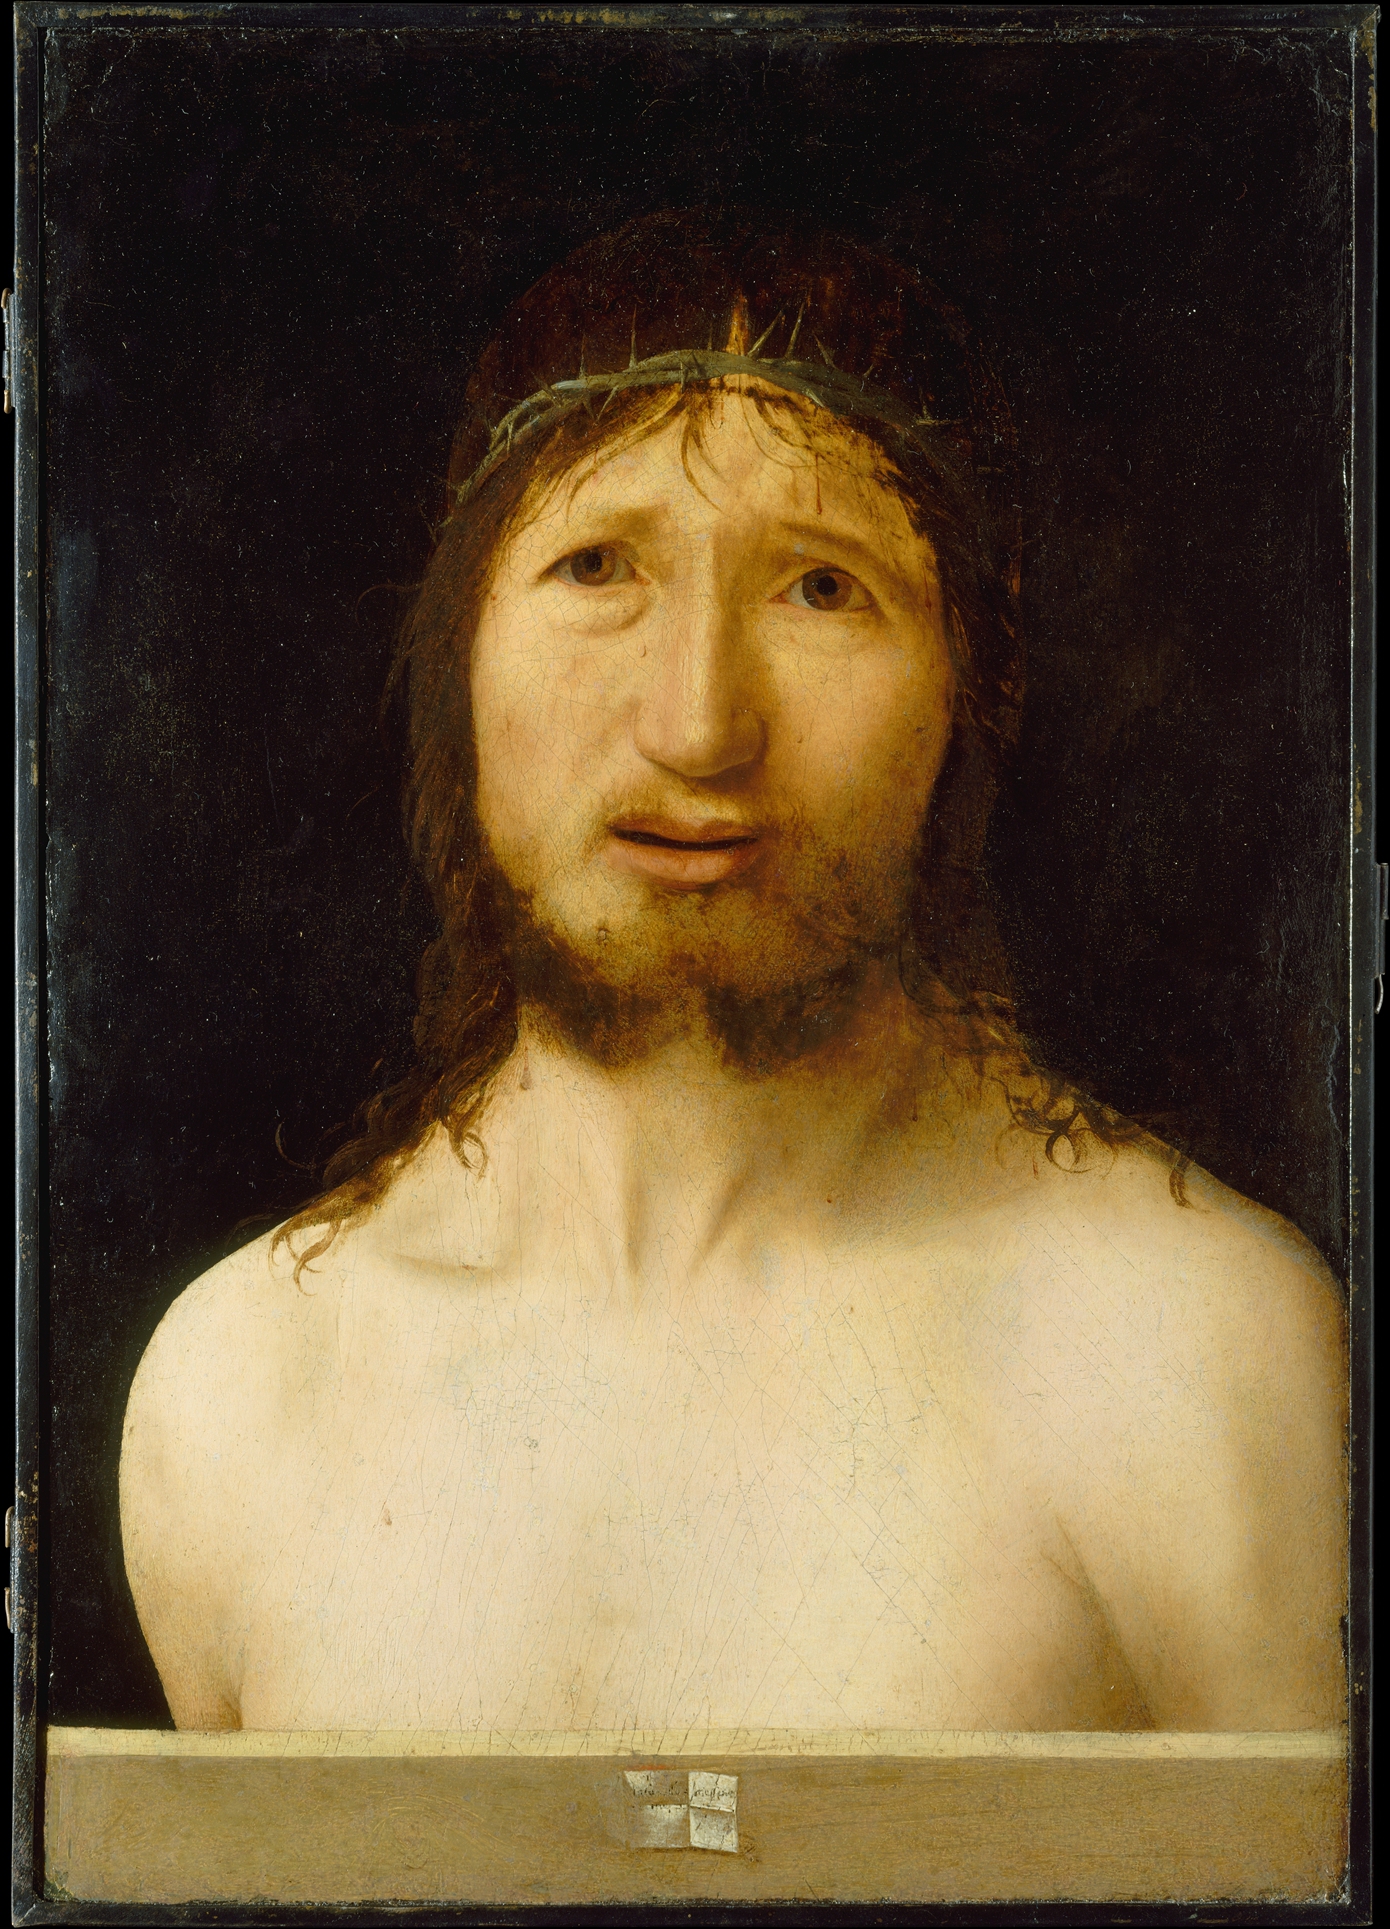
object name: painting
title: Christ Crowned with Thorns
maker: antonello da messina (antonello di giovanni d'antonio)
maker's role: artist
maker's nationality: italian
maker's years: 1430-1479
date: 1450-1479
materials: oil, paint, wood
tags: christ